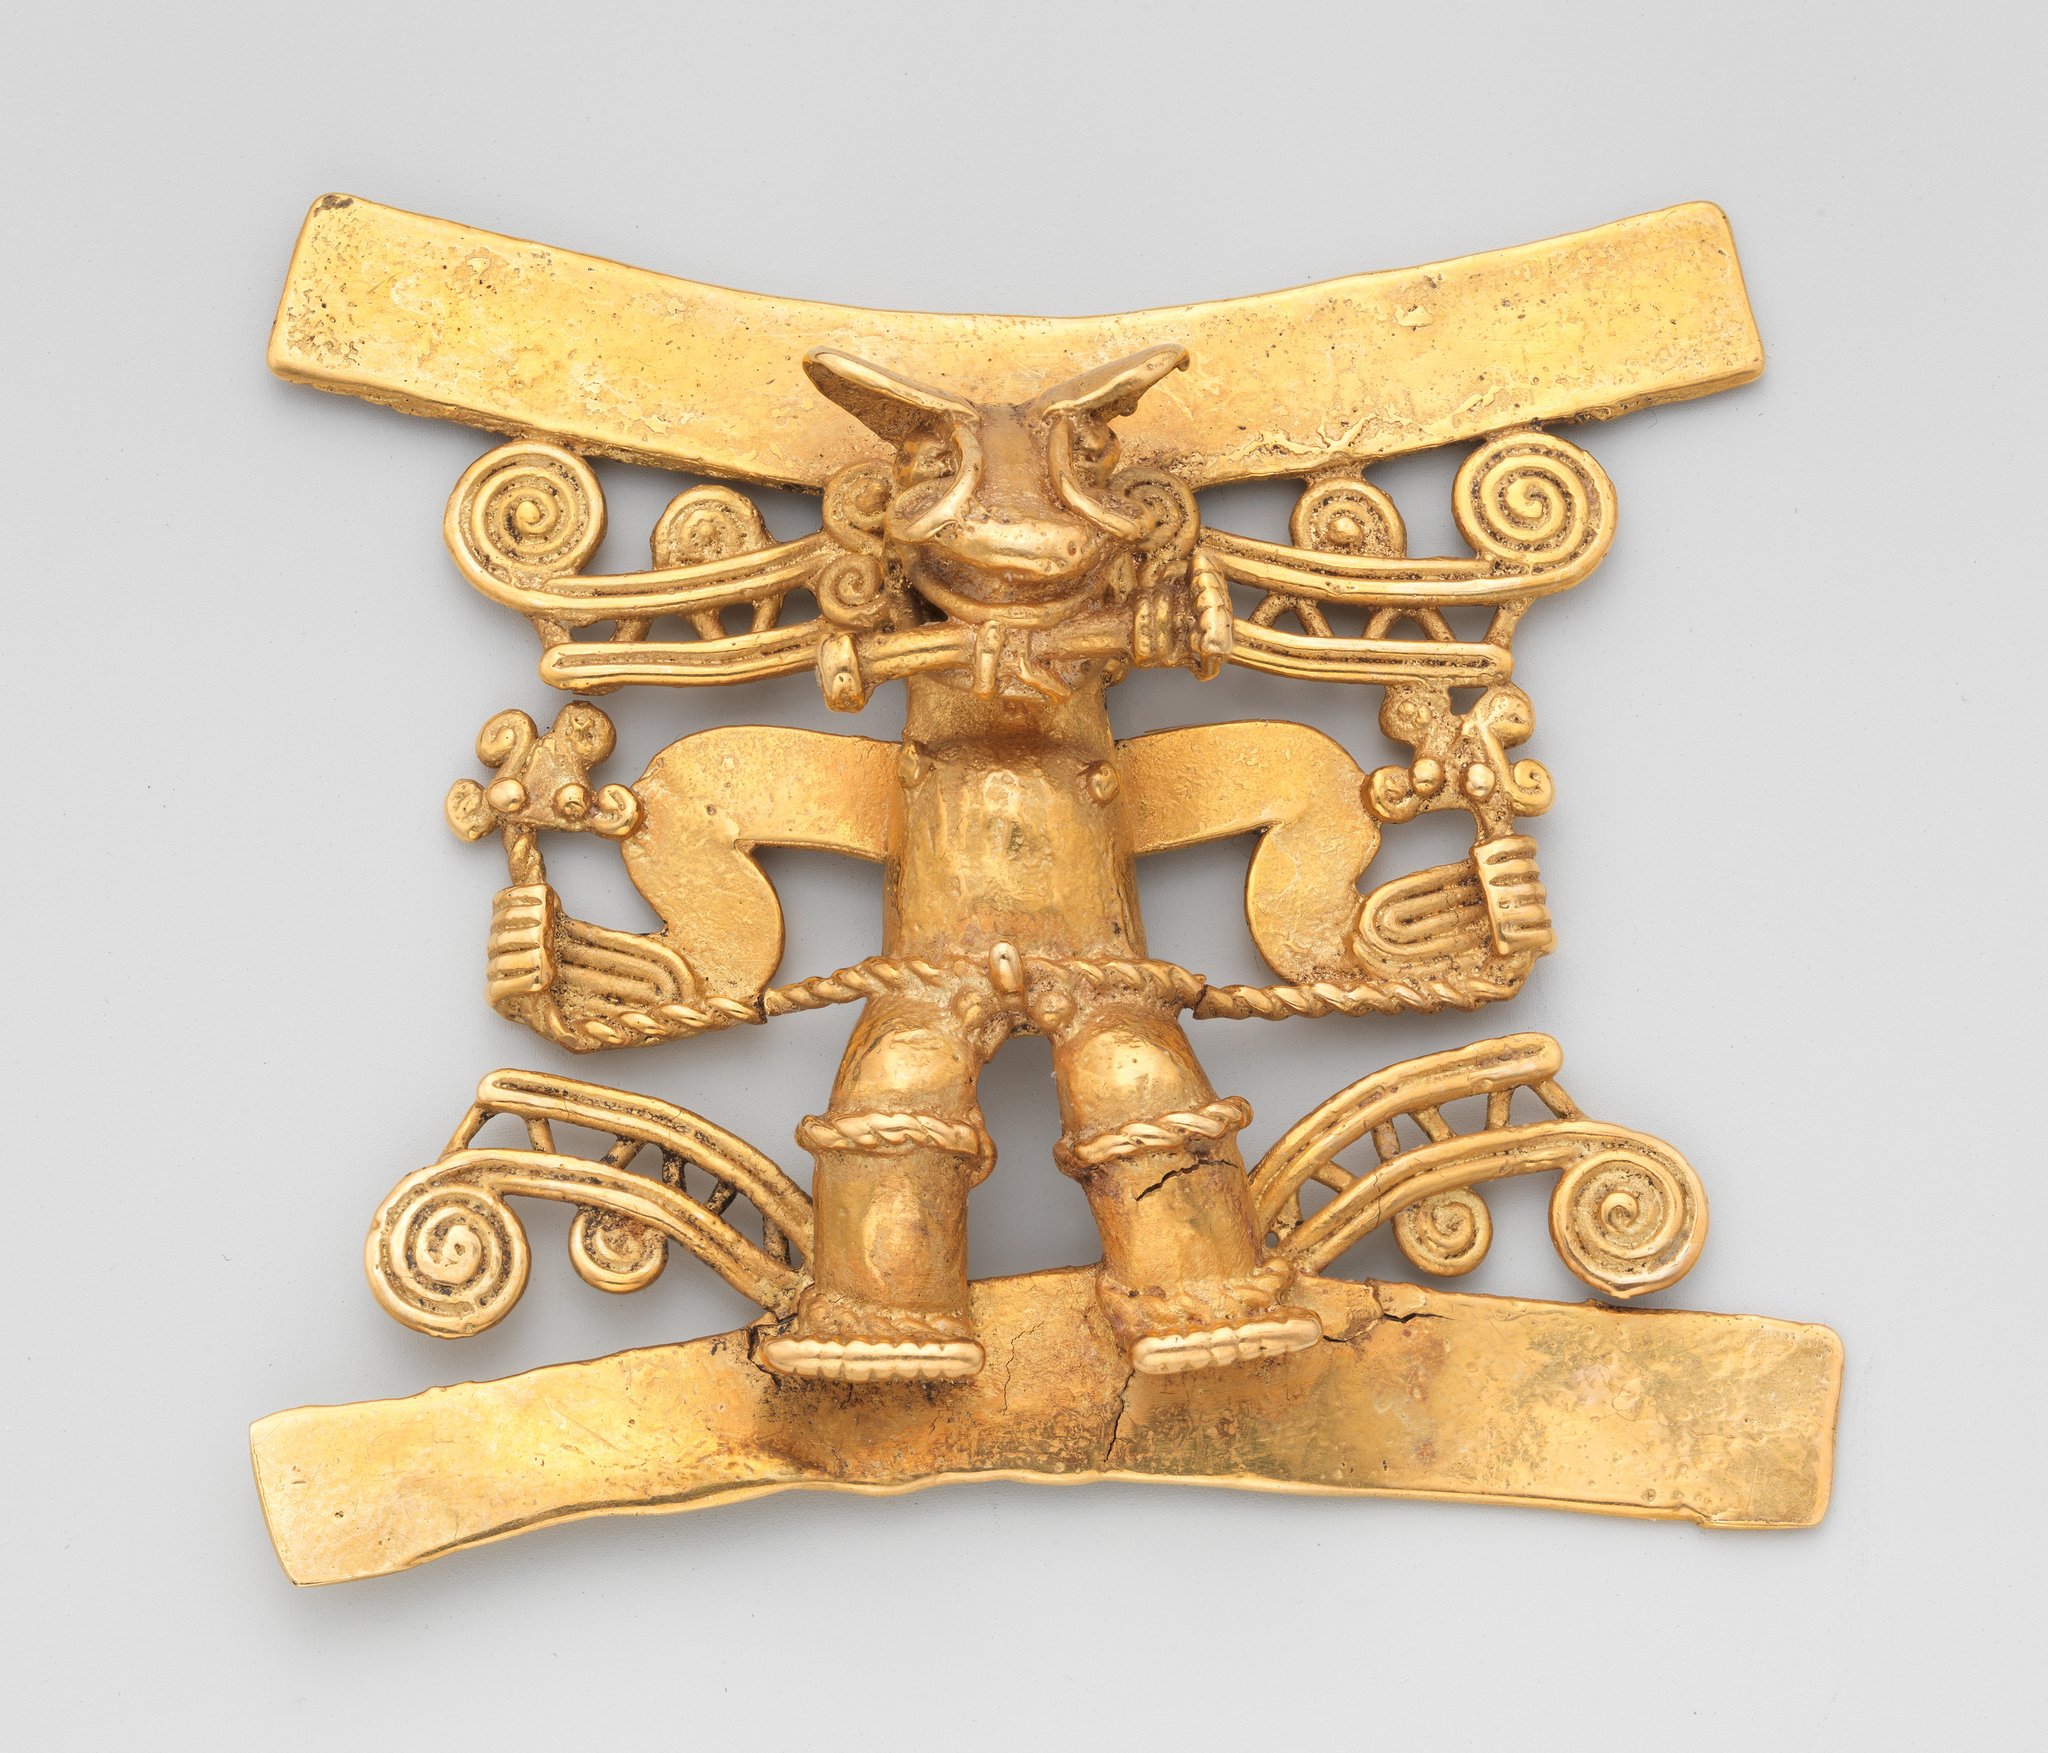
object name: pendant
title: Figure pendant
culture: diquís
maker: greater chiriquí artist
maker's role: artist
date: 700-1550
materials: gold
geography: costa rica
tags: mythical creatures,serpents